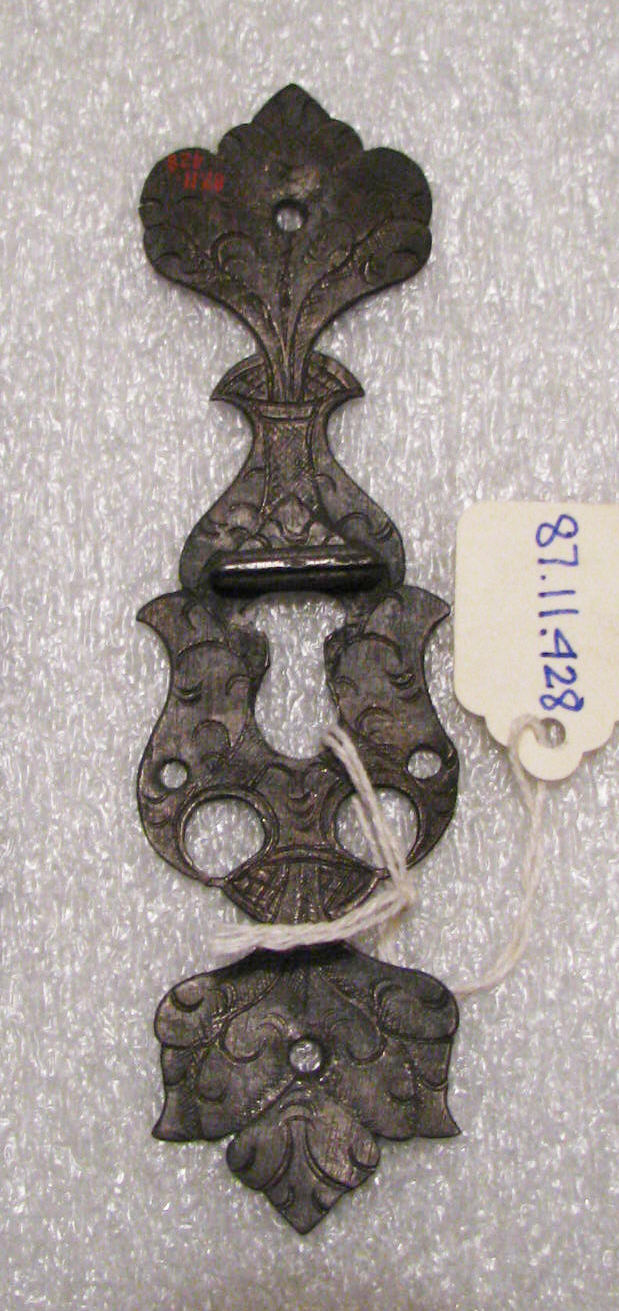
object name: escutcheon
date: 1580-1620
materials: iron